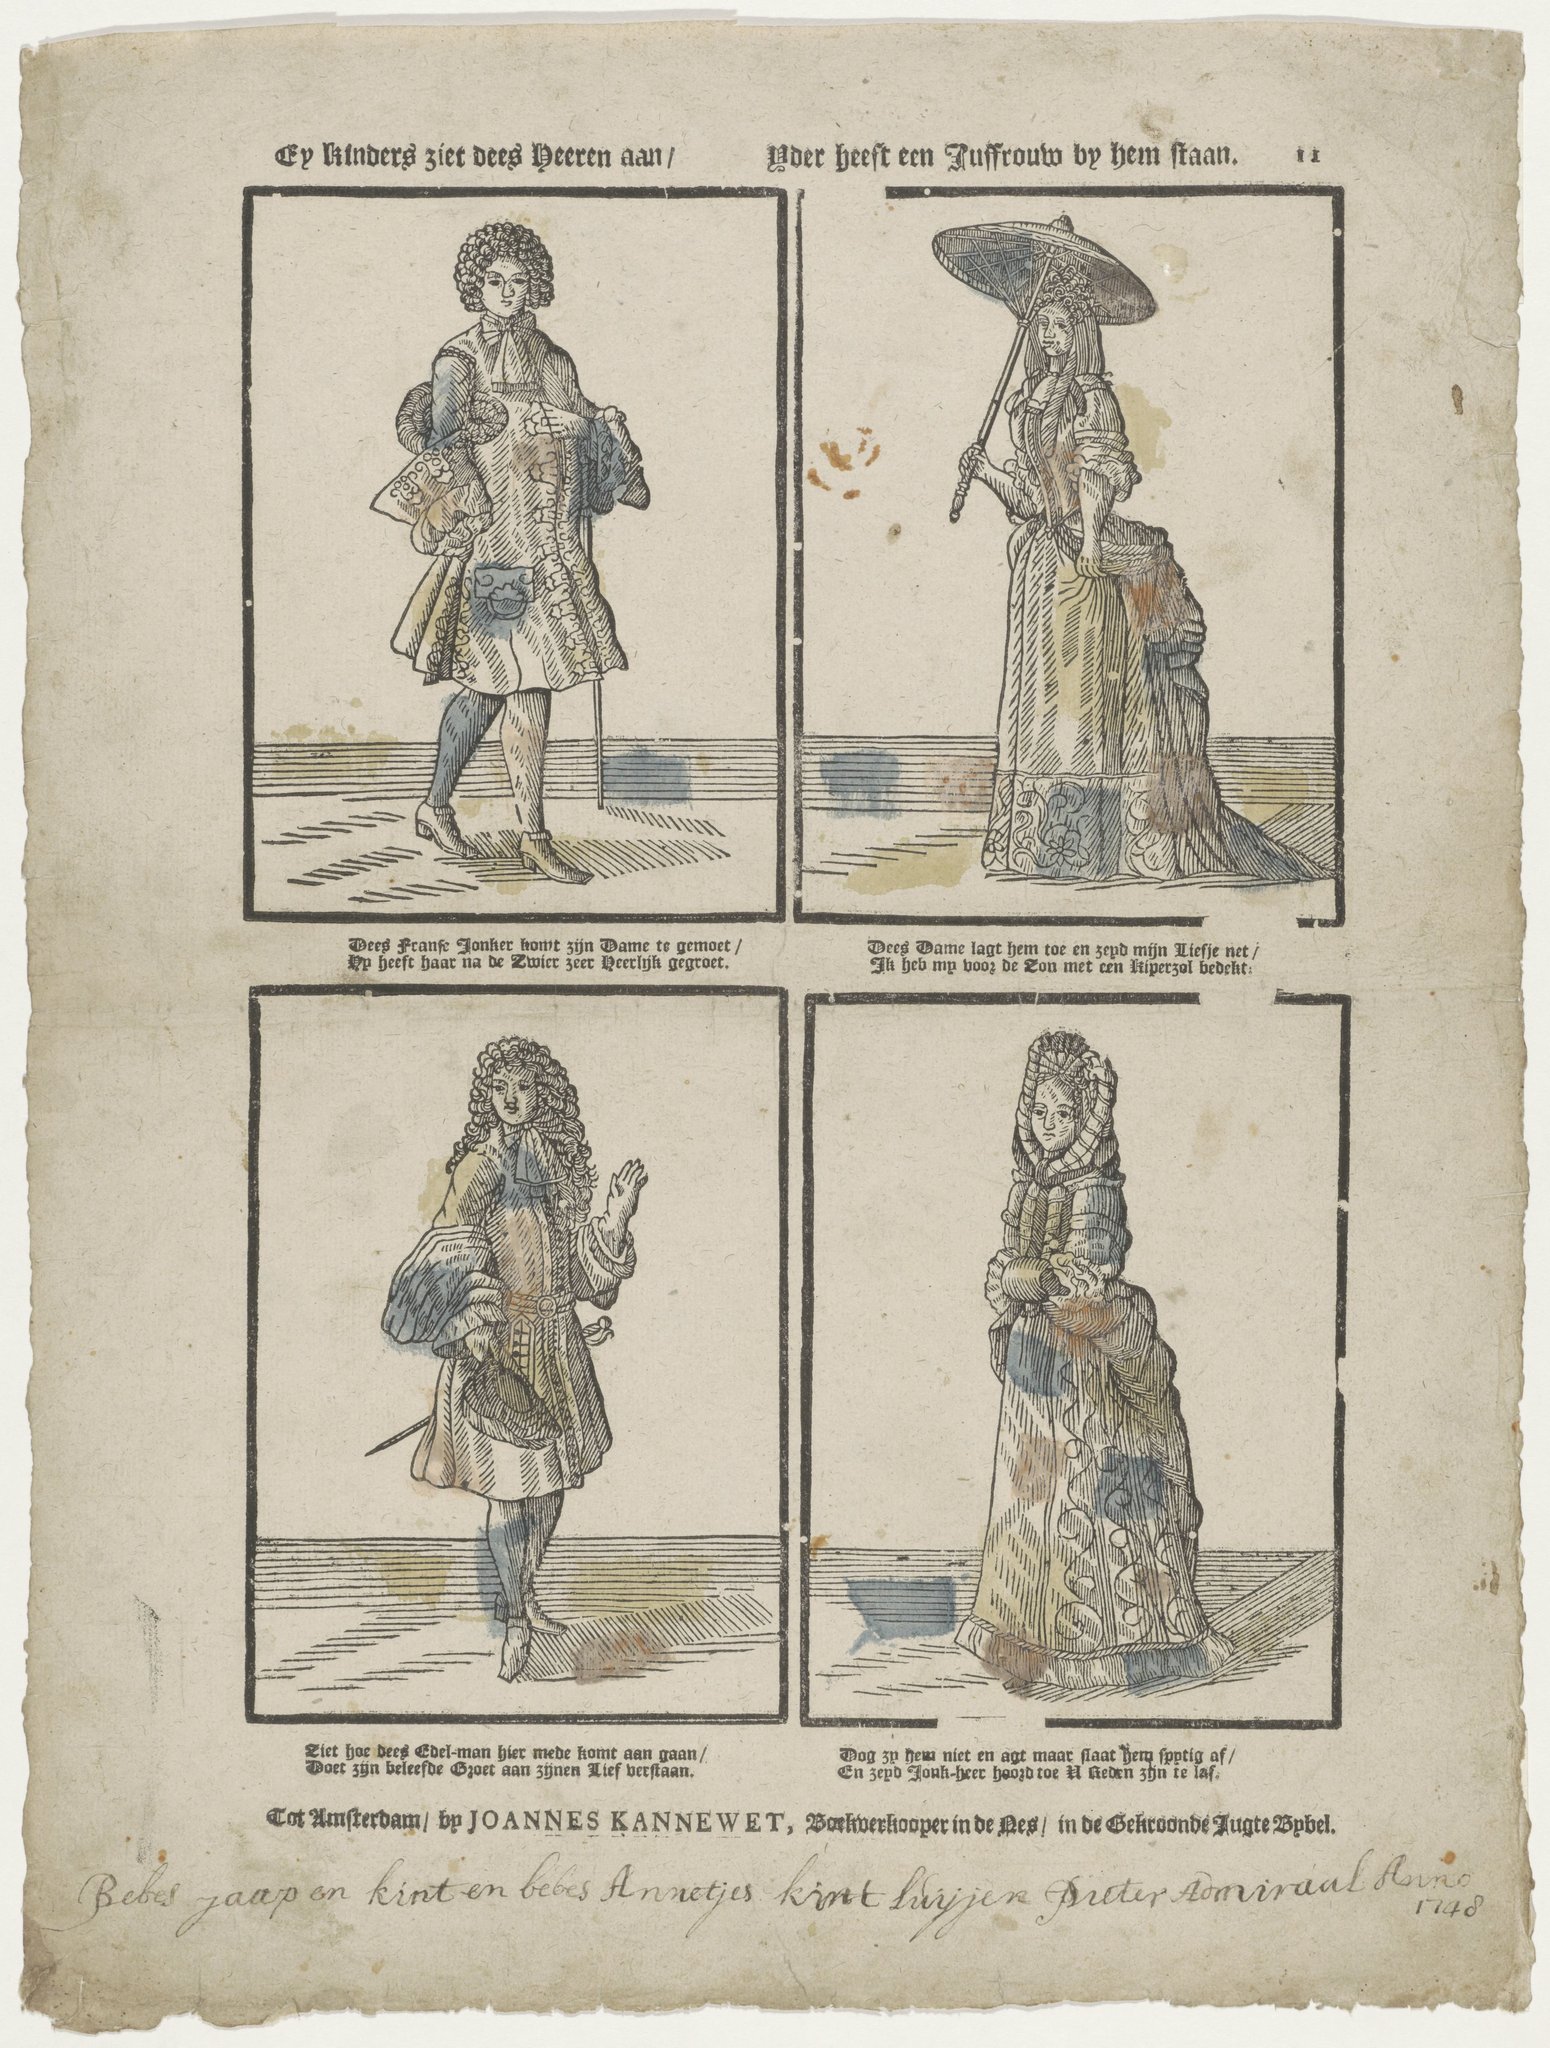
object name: popular print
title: Ey kinders ziet dees heeren aan / Yder heeft een juffrouw by hem staan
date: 1725-1780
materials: paper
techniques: colour, letterpress printing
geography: netherlands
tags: fashion, clothing, adult woman, adult man, nobility and patriciate; chivalry, knighthood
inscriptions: collector's mark: Lugt 2760, collector's mark: Lugt 2228, inscription: ‘Bebes Jaap en kint en bebes Annetjes kint Luyjen Pieter Admiraal Anno / 1748’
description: Blad met 4 voorstellingen. Twee voorstellingen van heren en twee voorstellingen van dames. Onder elke afbeelding een tweeregelig vers. Genummerd rechtsboven: 11.